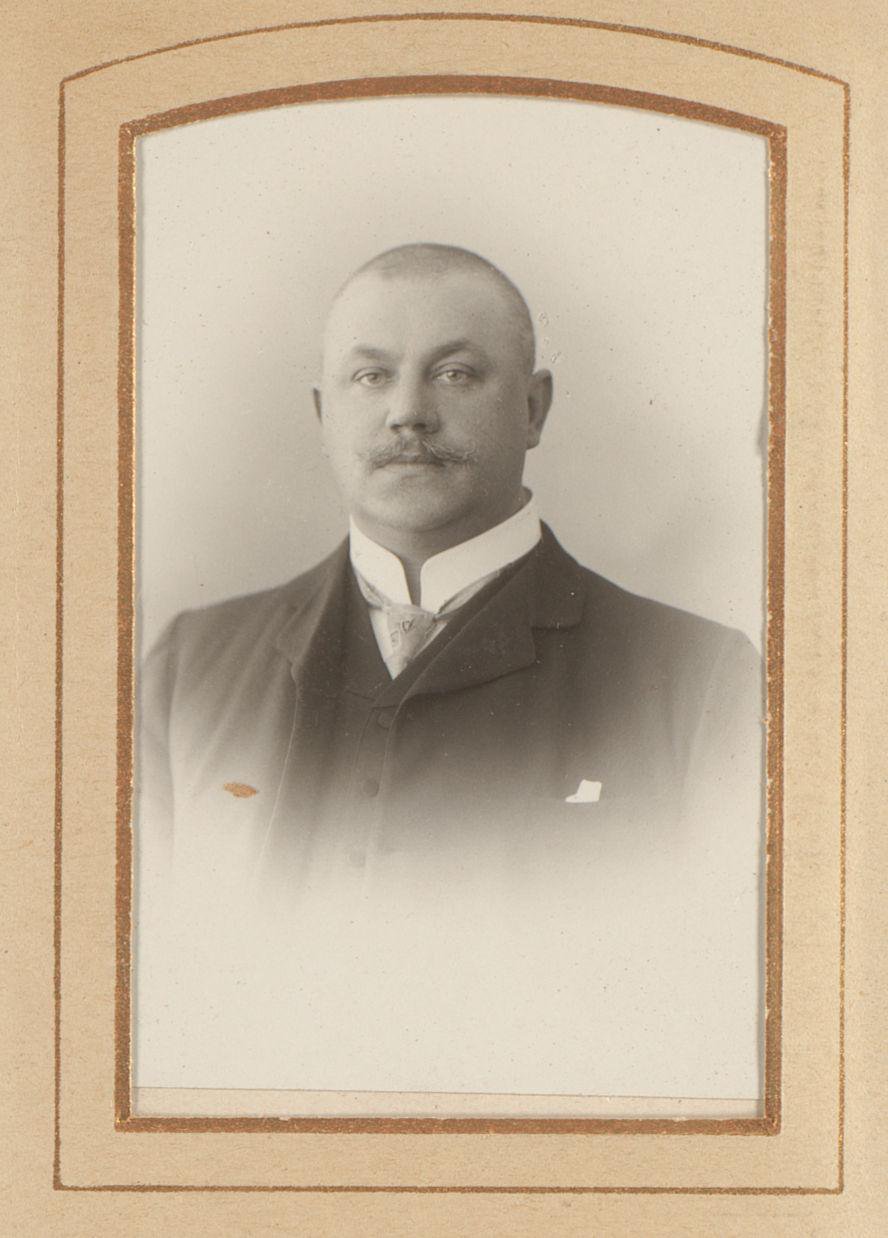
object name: carte de visite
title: Portret van een man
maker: johannes jr. baer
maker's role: fotograaf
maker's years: 1864-1940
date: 1892-1920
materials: cardboard, photographic support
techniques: collodion silver print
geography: the hague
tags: historical persons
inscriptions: inscription: ‘Baer/ Prinsestraat No90/ 's Gravenhage/ Atelier voor Fotografie’